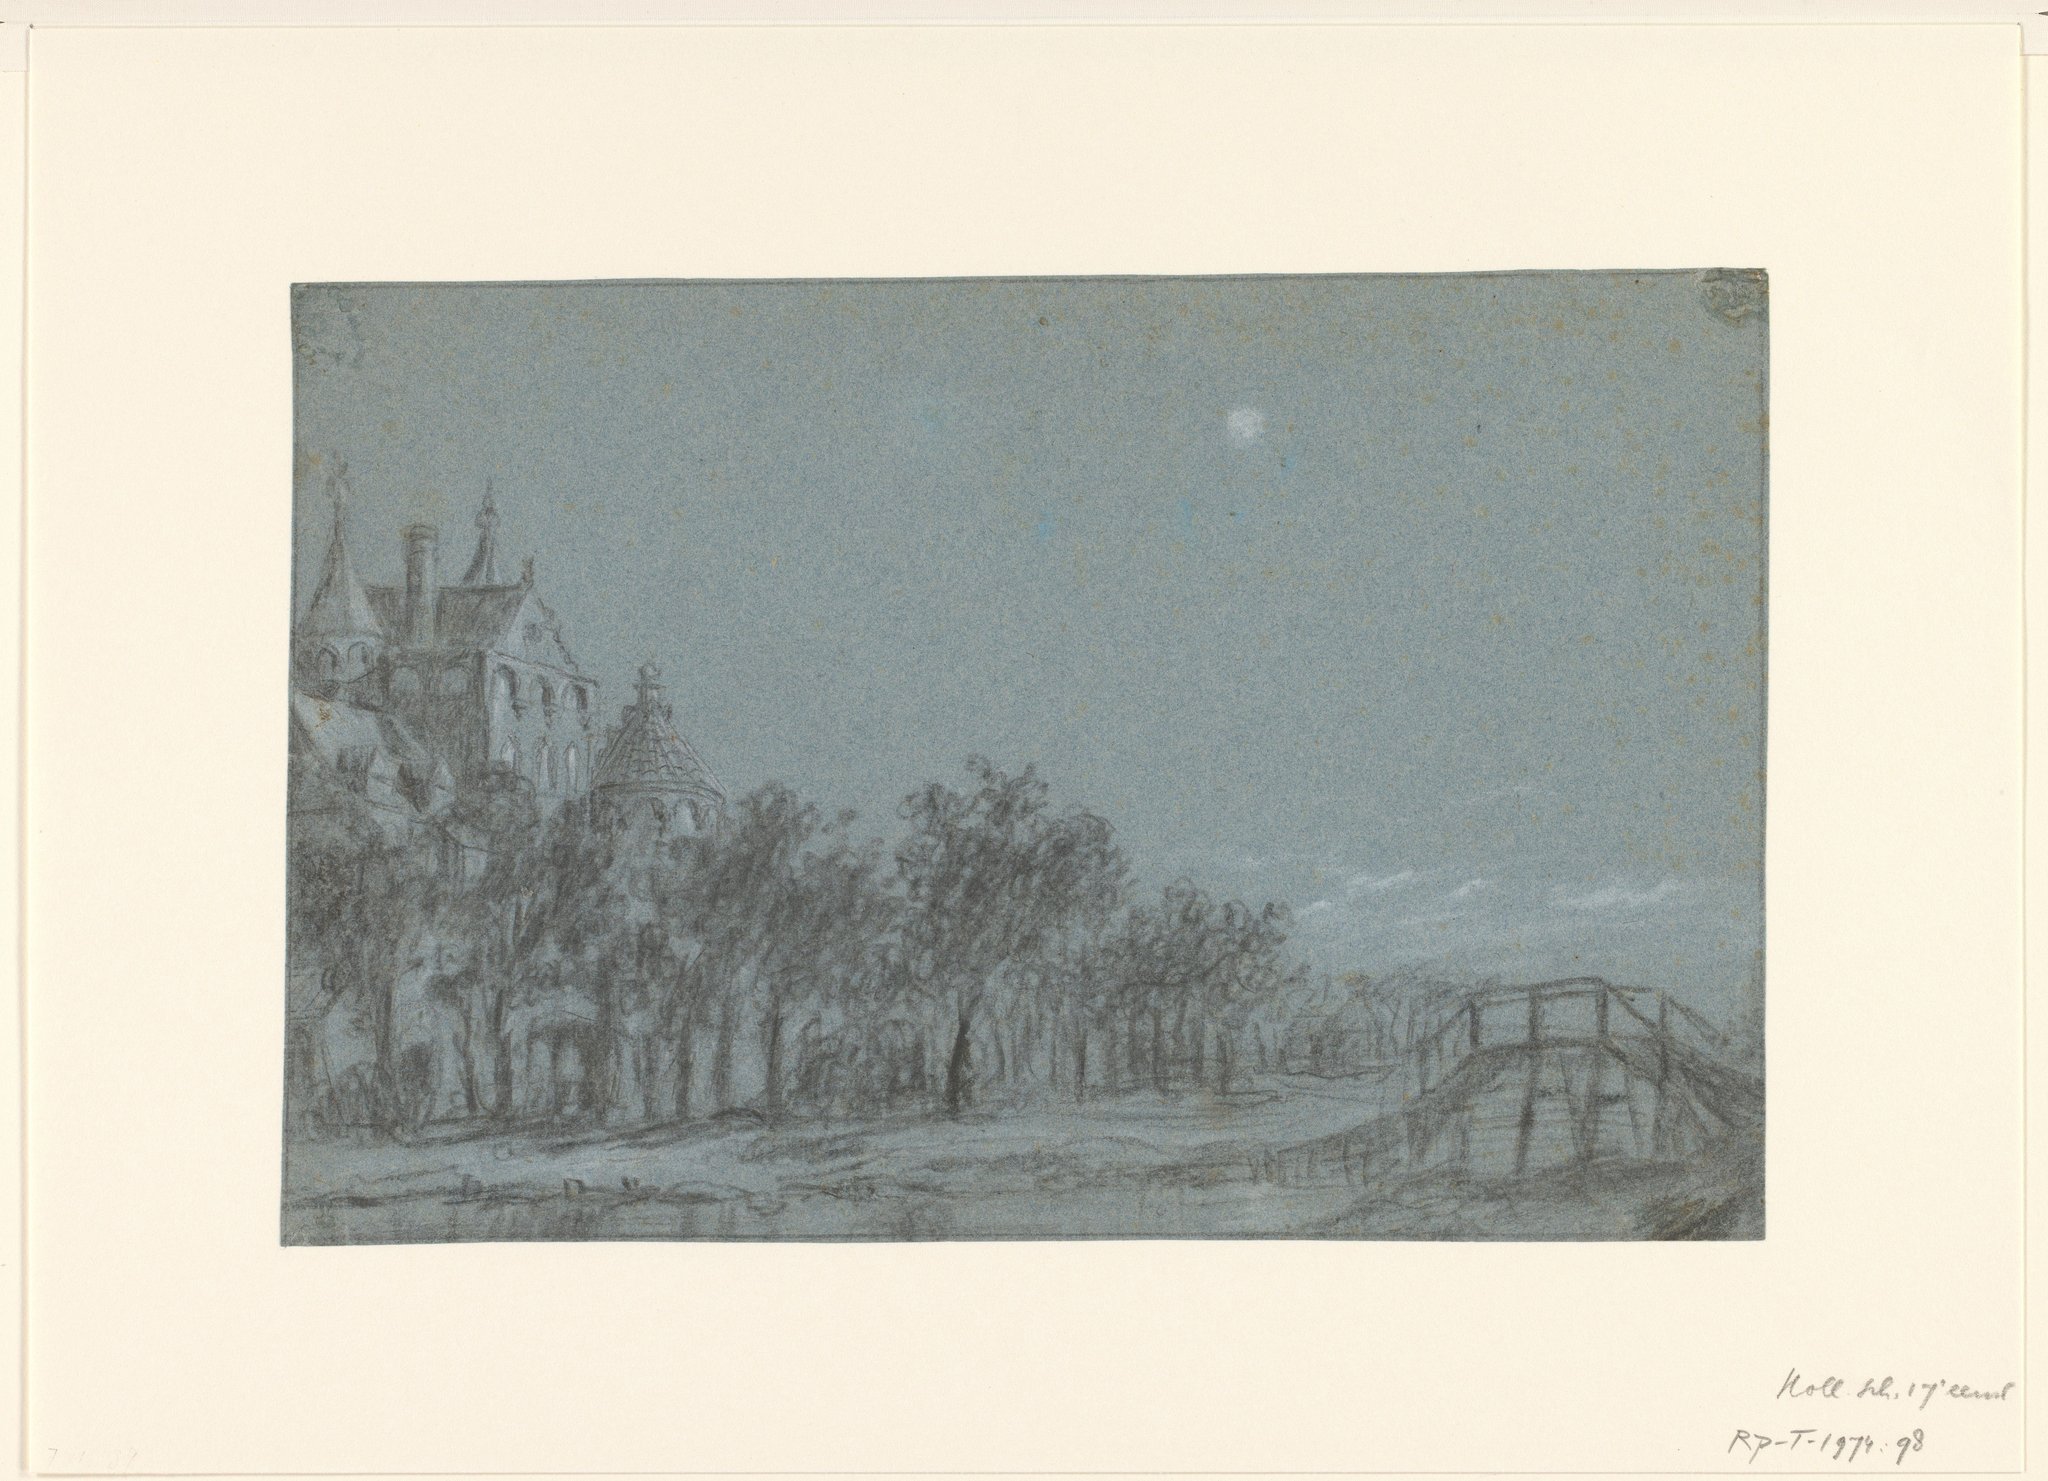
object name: drawing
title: Kerkgebouw achter bomenrij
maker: Anonymous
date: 1600-1699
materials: chalk, paper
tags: landscape with bridge, viaduct or aqueduct, landscapes with waters, waterscapes, seascapes (in the temperate zone), church (exterior)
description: Kerkgebouw achter bomenrij langs een vaart met een voetbrug.